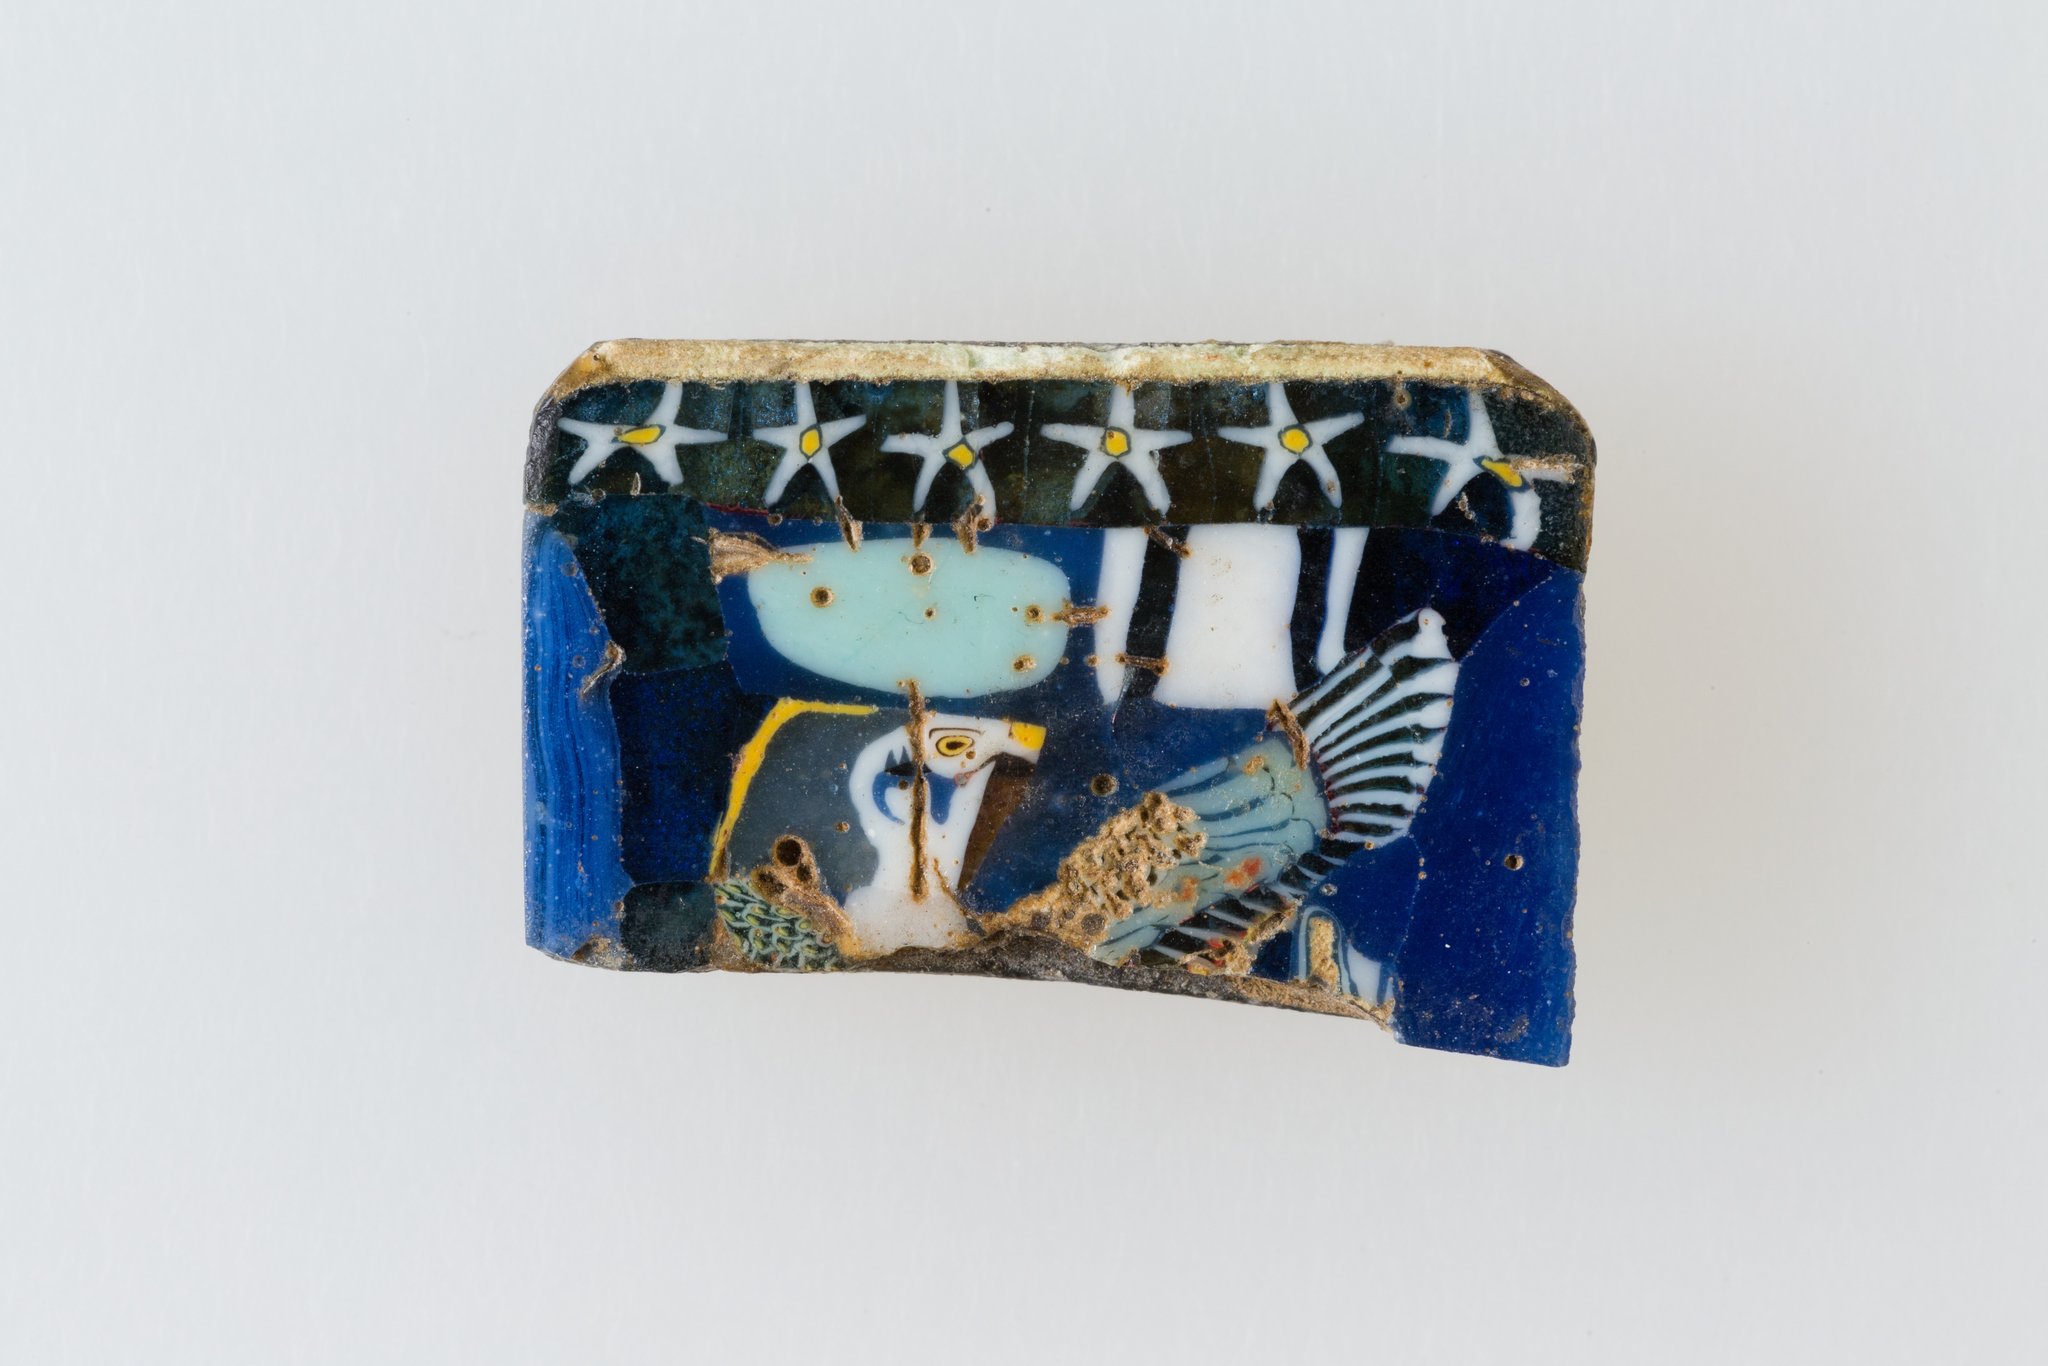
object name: plaque, falcon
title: Inlay, falcon with spread wings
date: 100 BCE-100 CE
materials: glass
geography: egypt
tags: falcons